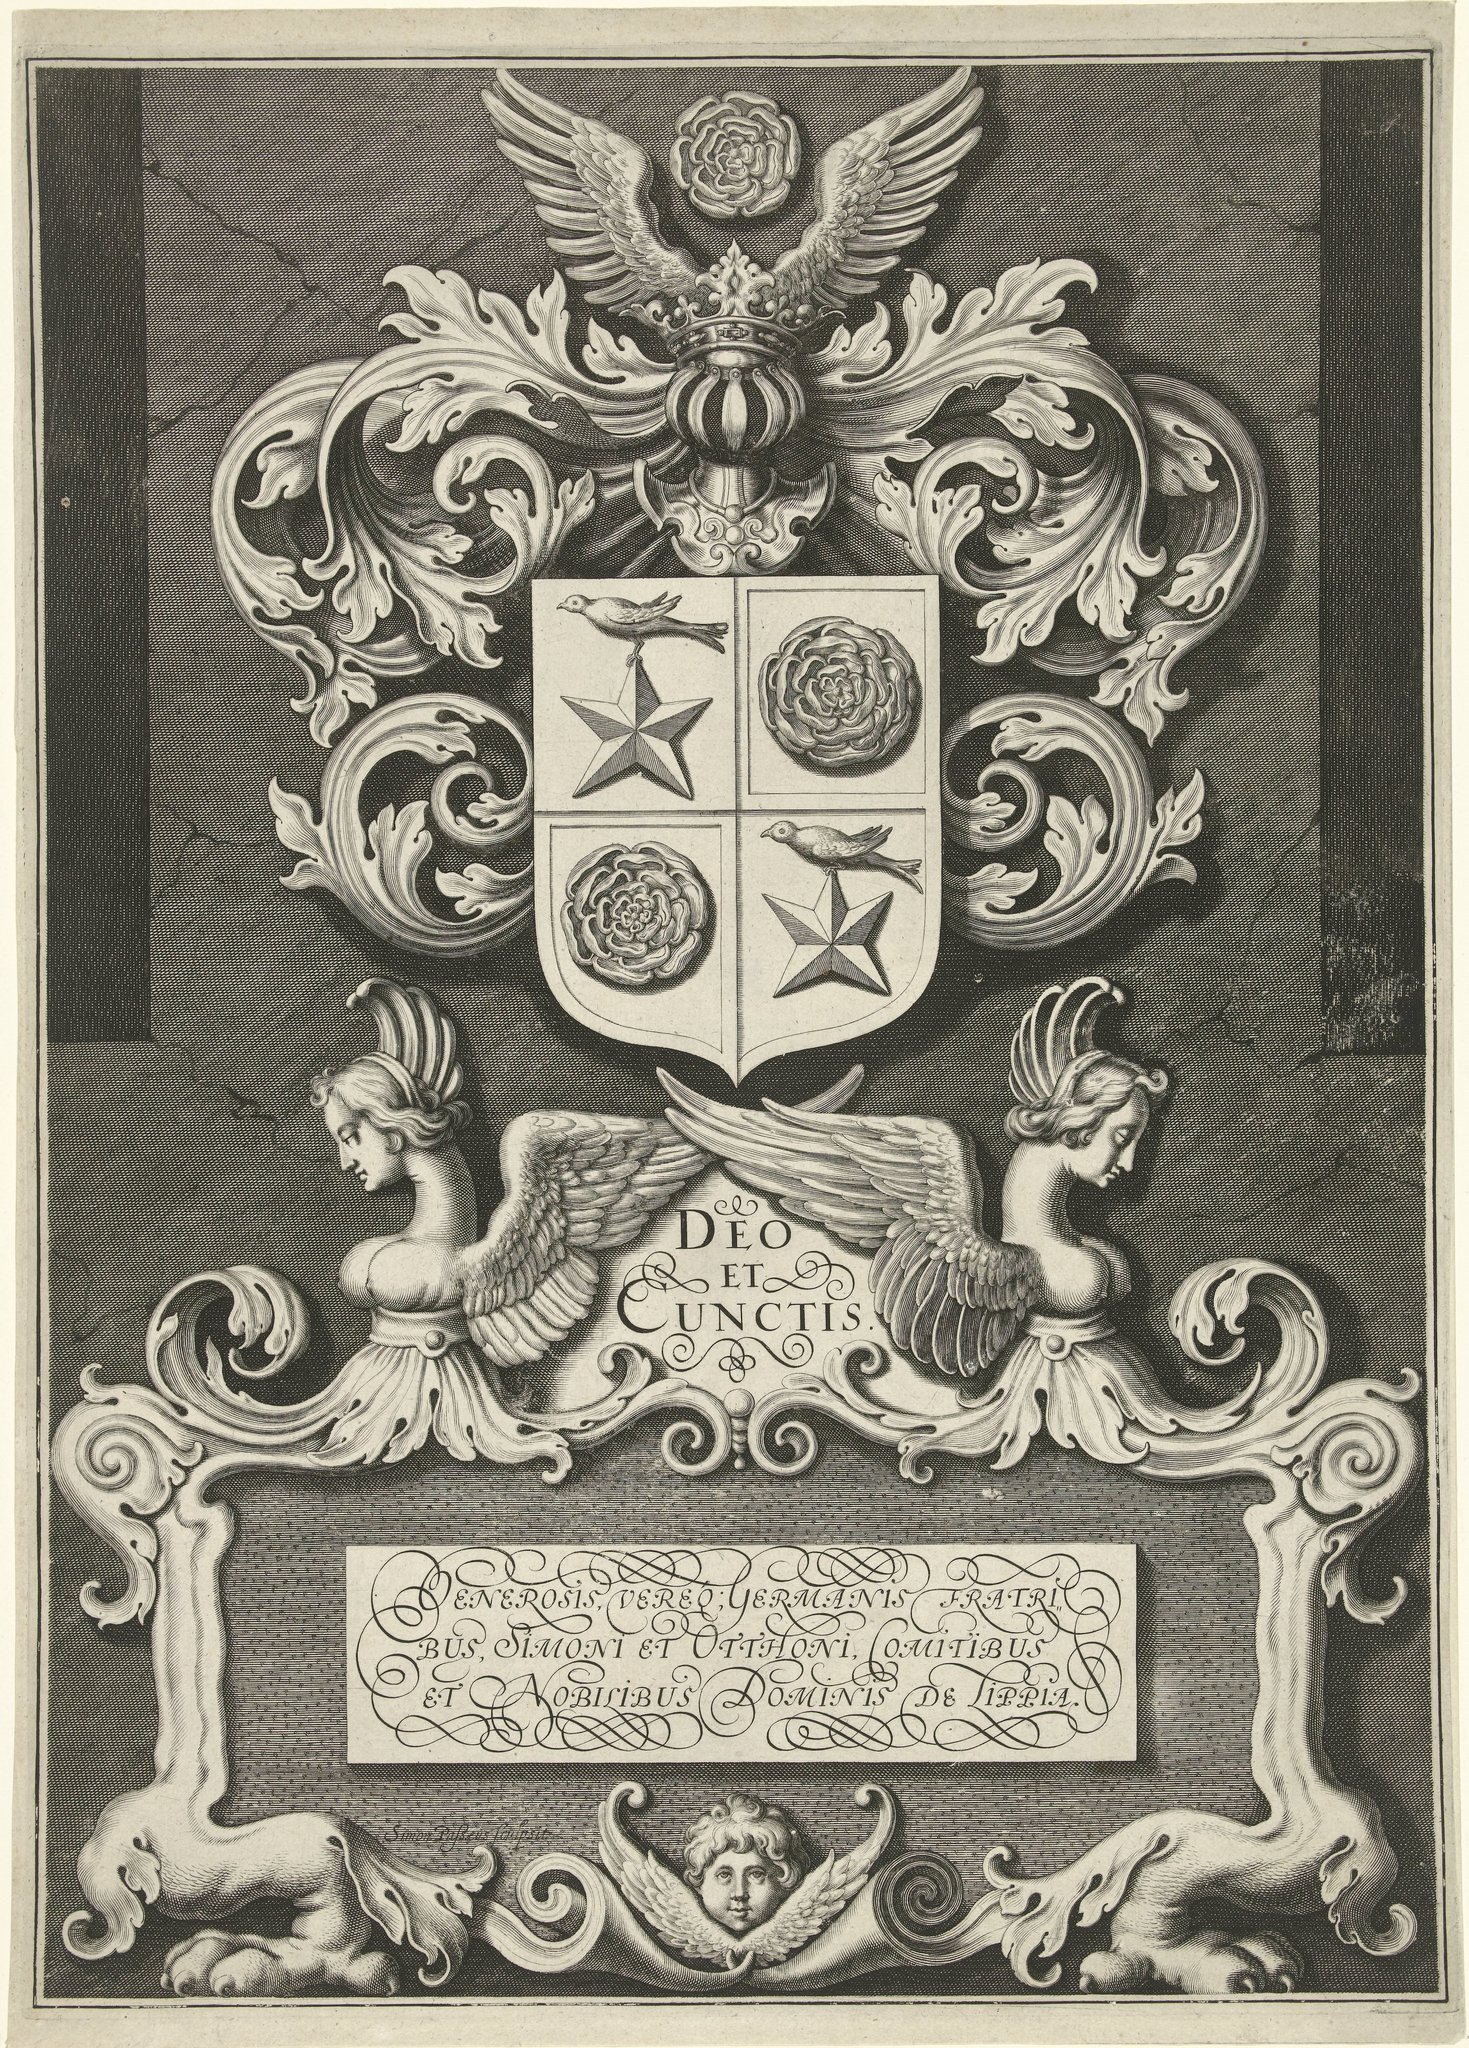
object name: print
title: Wapenschild van de gebroeders Simon en Otto, graven van Lippe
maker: simon van de passe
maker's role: print maker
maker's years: 1595-1647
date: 1628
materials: paper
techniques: engraving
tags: armorial bearing, heraldry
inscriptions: collector's mark: Lugt 2166, collector's mark: Lugt 2760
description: Wapenschild van Simon en Otto, graven van Lippe. Daaronder in een met bustes van sfinxen versierd cartouche hun devies in het Latijn en een kader met de namen van de gebroeders in het Latijn.